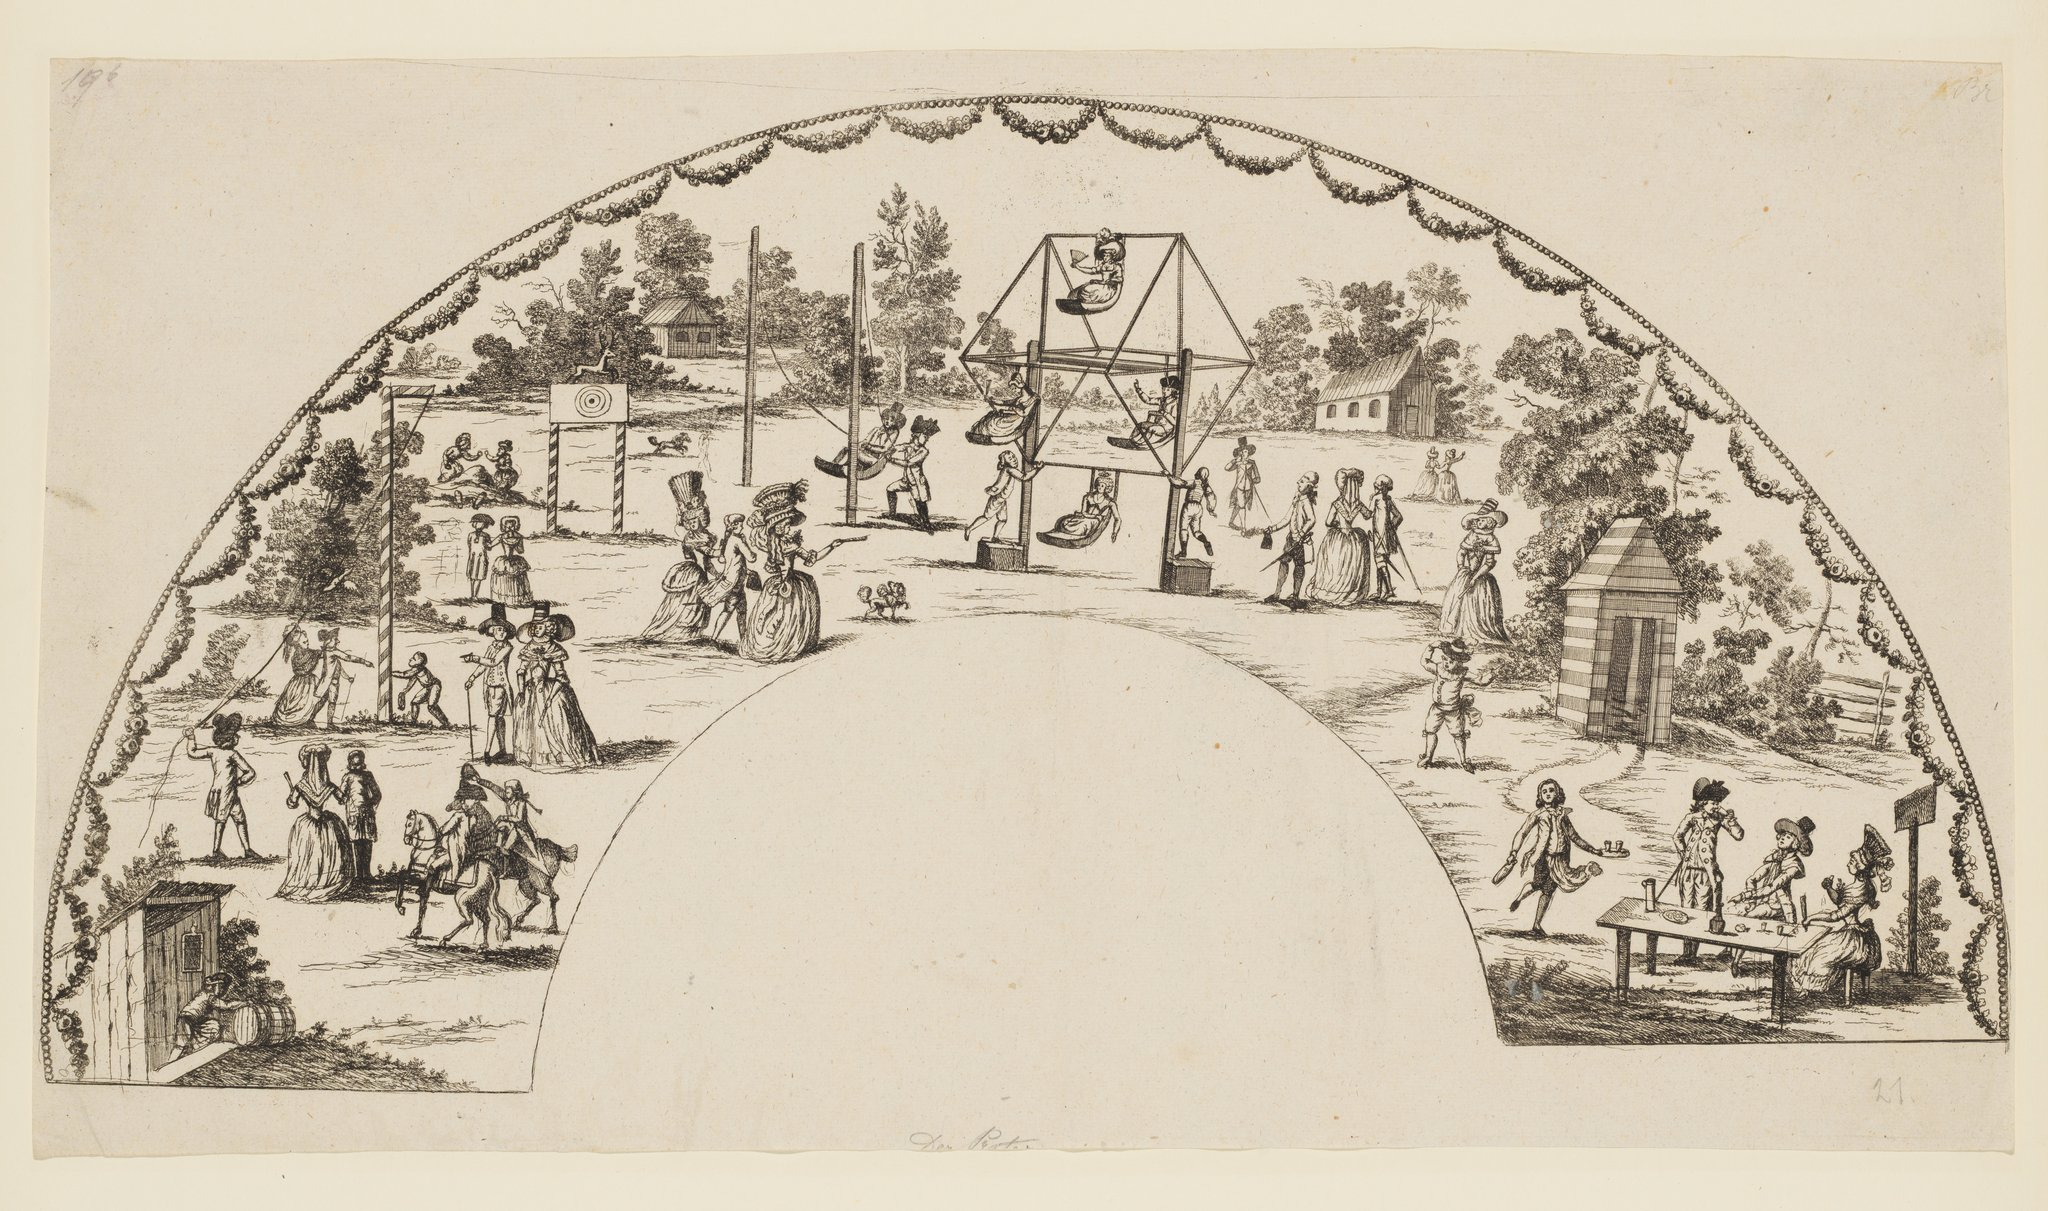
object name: print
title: Design for a fan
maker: anonymous, austrian, 18th century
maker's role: artist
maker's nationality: austrian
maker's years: 1700-1800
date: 1701-1800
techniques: etching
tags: fans,women,amusement parks